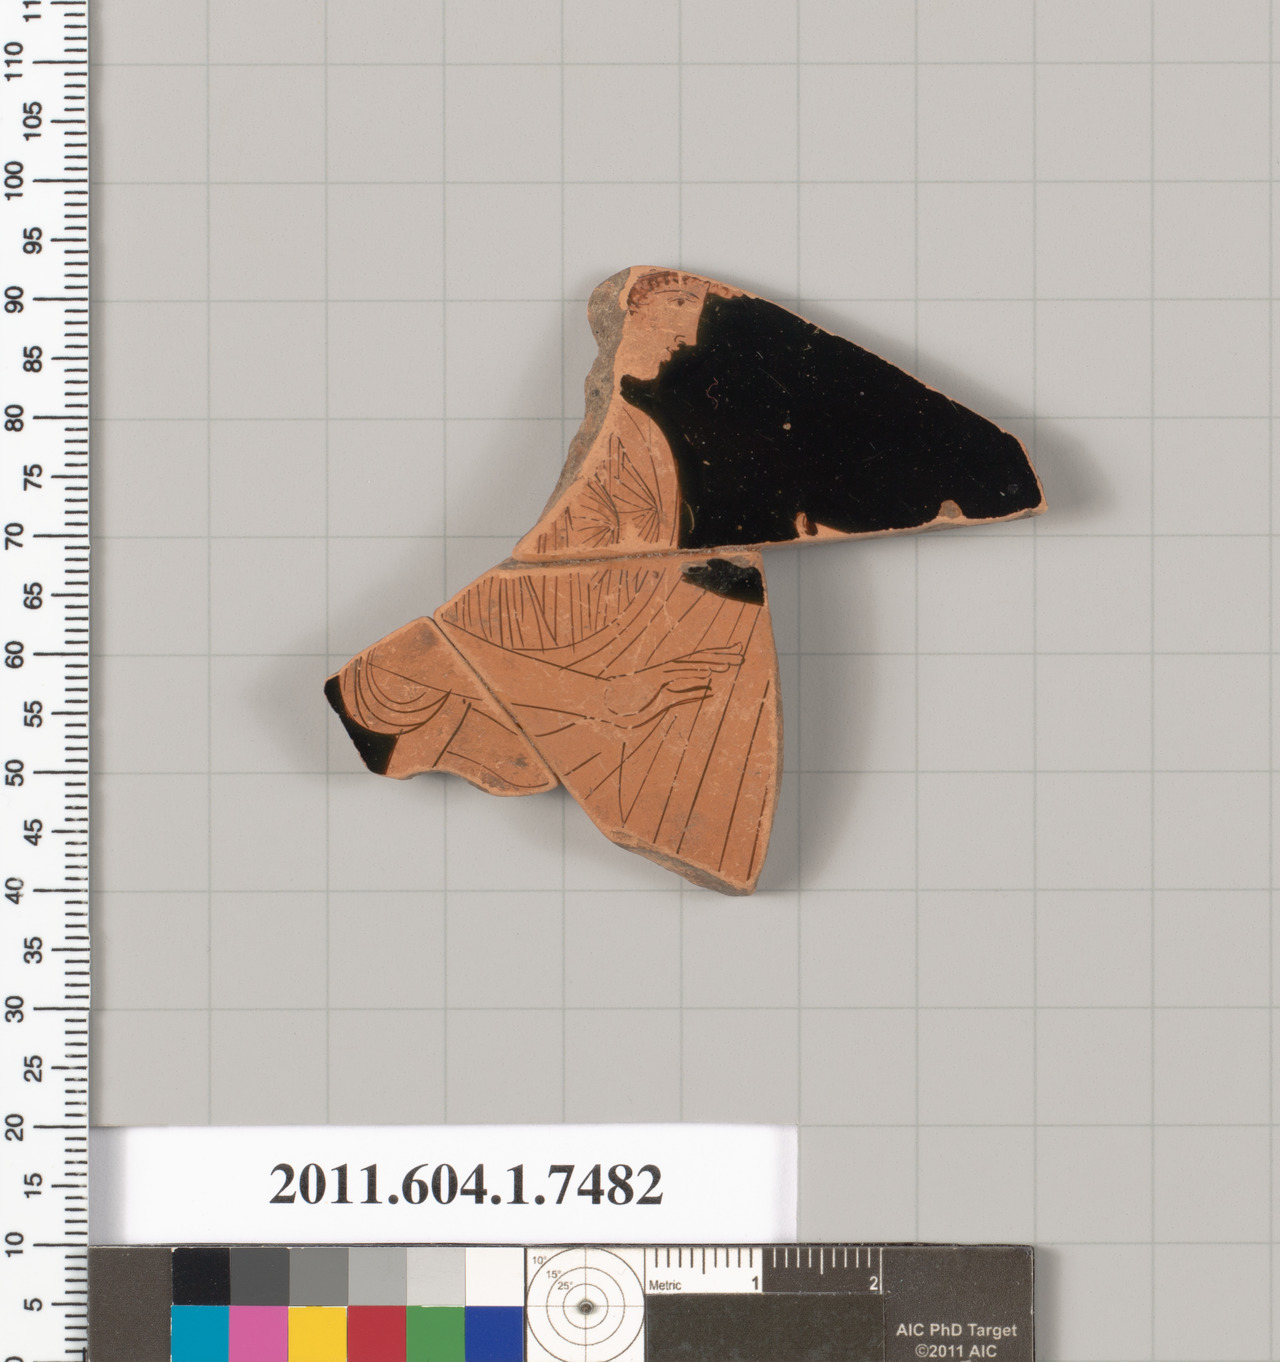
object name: kylix fragment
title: Terracotta fragment of a kylix (drinking cup)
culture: greek, attic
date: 460-450 BCE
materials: terracotta